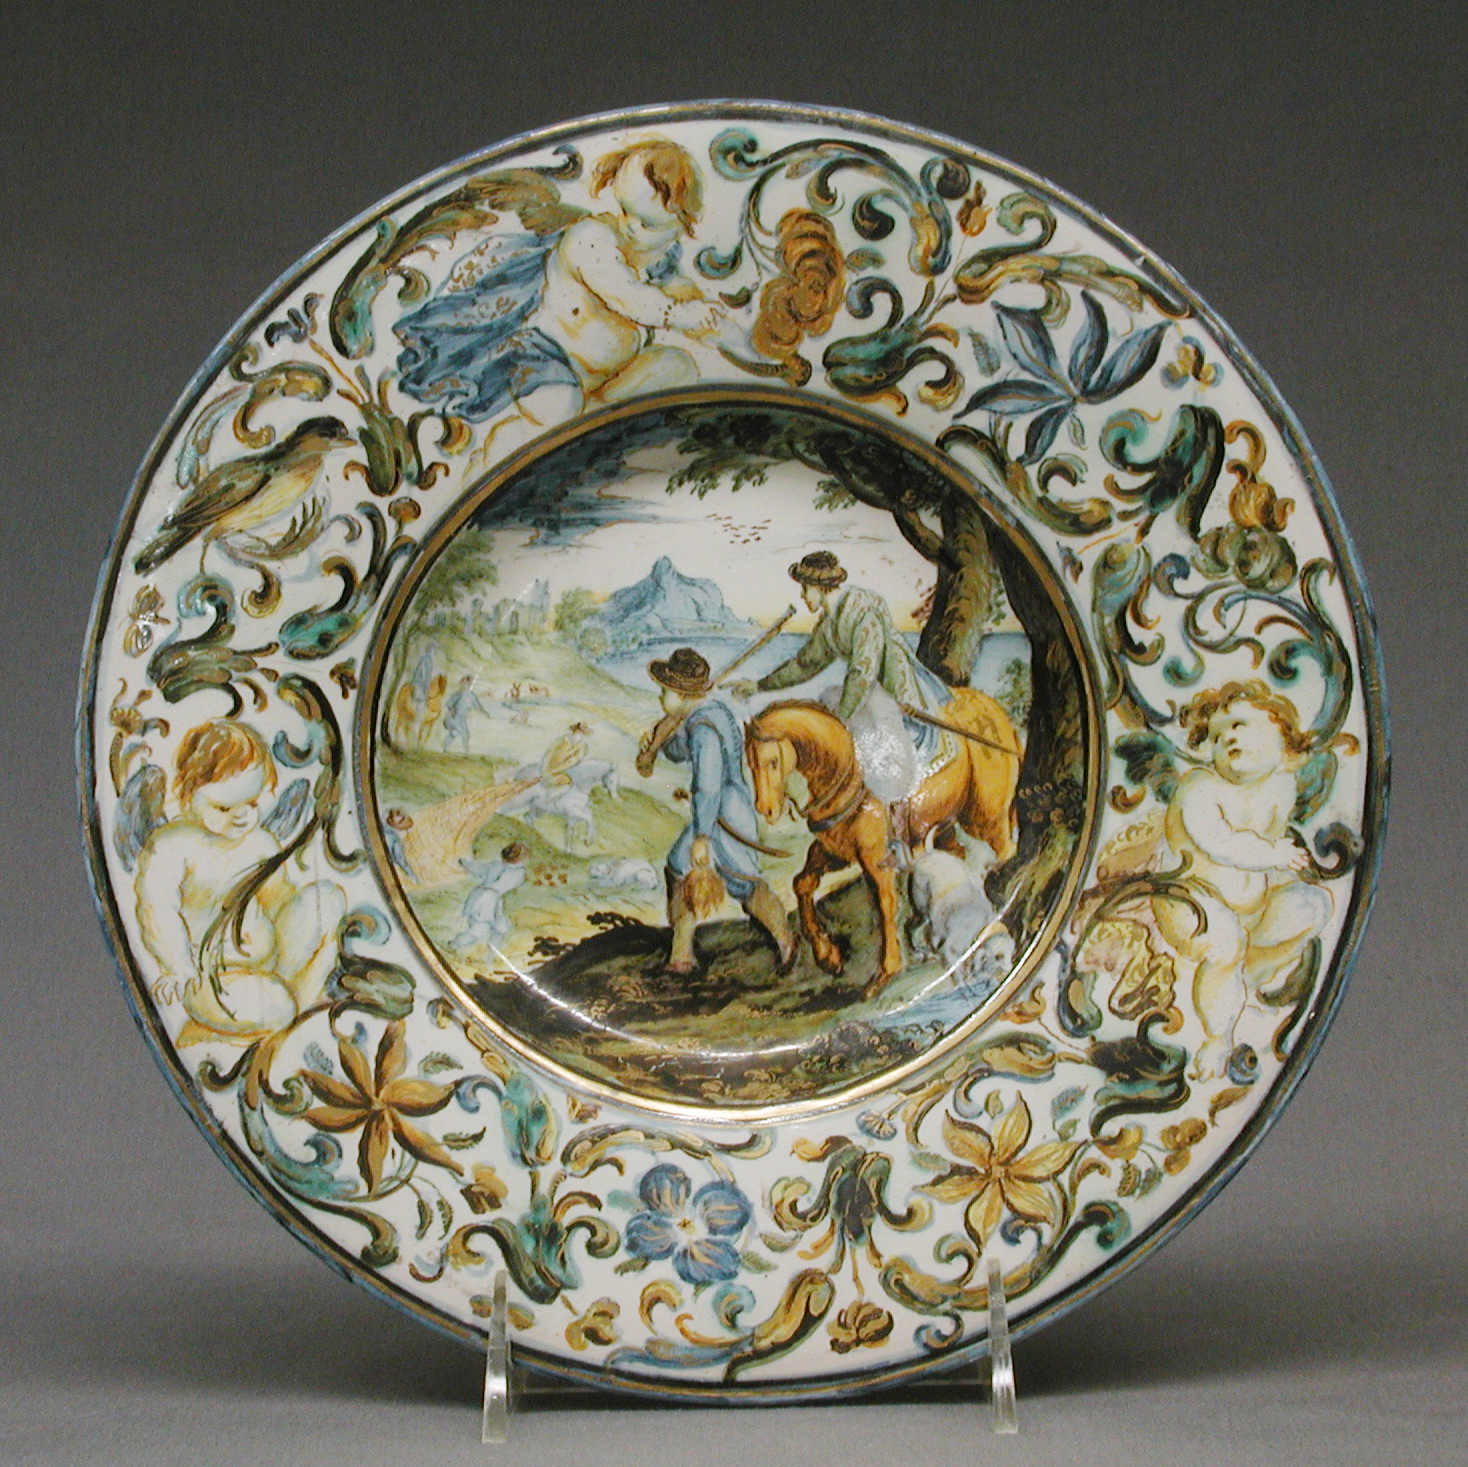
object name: plate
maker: francesco grue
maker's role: maker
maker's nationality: italian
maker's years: 1618-1673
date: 1670-1679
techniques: maiolica, glazing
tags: human figures,infants,horses,flowers